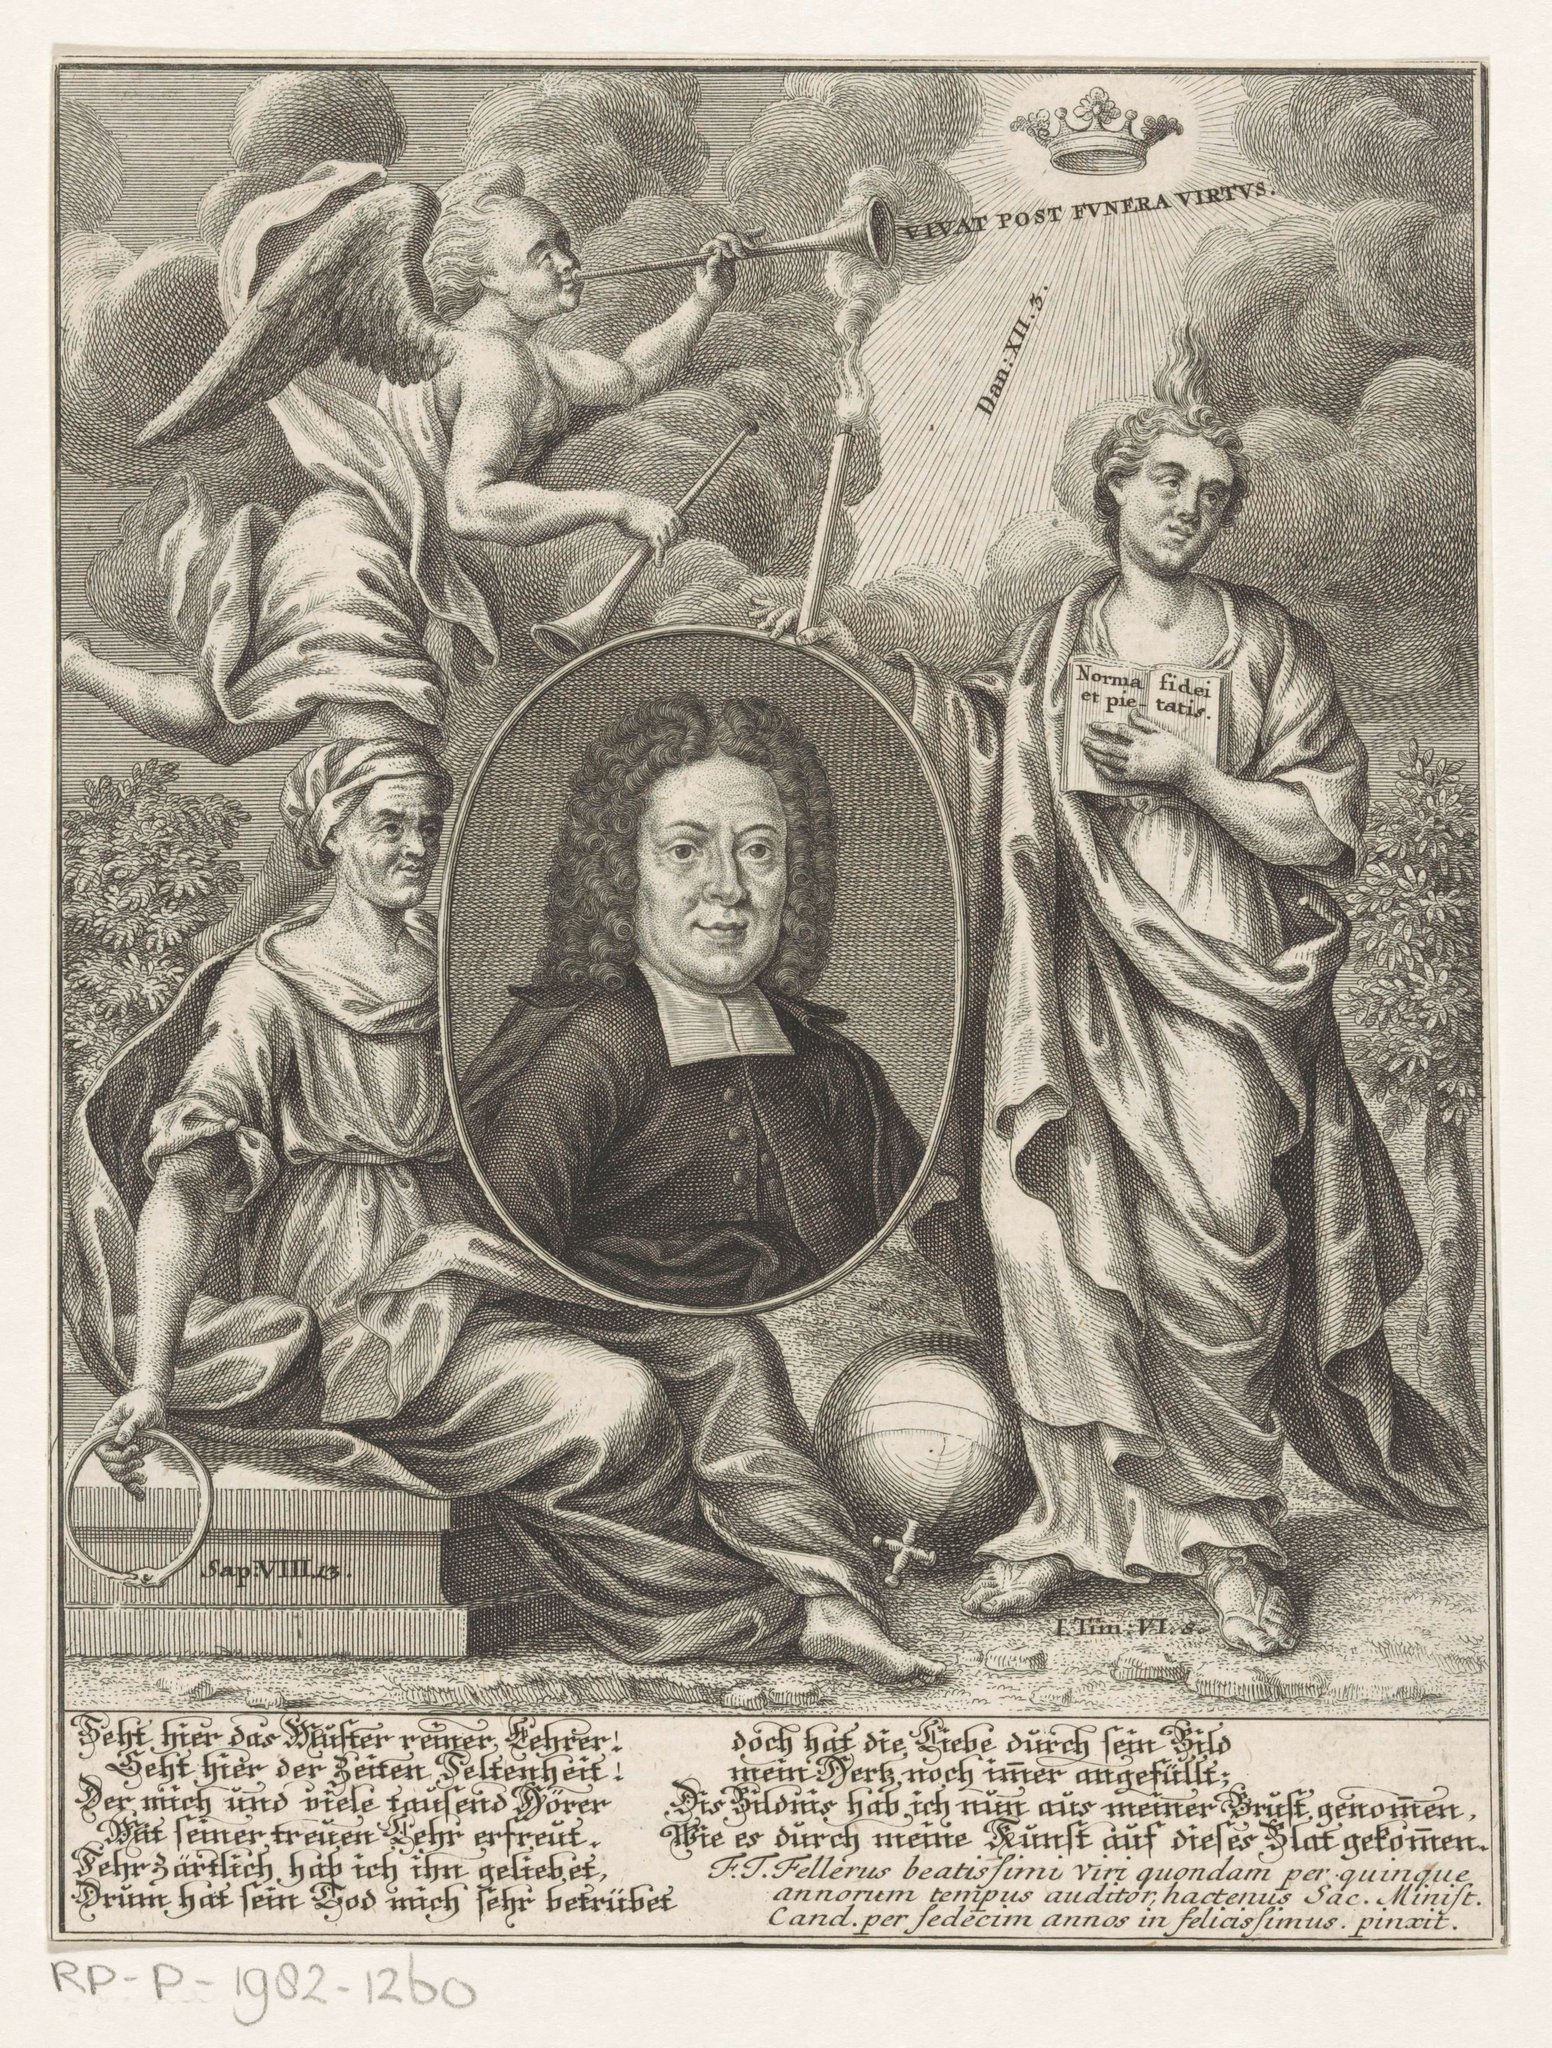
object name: print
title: Allegorische voorstelling met portret van Joachim Feller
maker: Anonymous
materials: paper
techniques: engraving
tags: zwickau, joachim feller, portrait of a writer, old woman, serpent ouroboros, fame; 'fama', 'fama buona', 'fama chiara' (ripa)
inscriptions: collector's mark: Lugt 2760, collector's mark: Lugt 2228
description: Een vrouw (mogelijk Vroomheid) met vlam op het hoofd, fakkel en boek in de hand staat rechts van een portretmedaillon van schrijver Joachim Feller. Links zit een oude vrouw met de slang Ourobouros in haar hand. Boven het portret vliegt Fama blazend op haar bazuin waaruit een tekst komt: Vivat post funera virtus. Boven de tekst een kroon in stralenkrans. Aan de onderzijde een tienregelige Duitse en drieregelige Latijnse tekst.